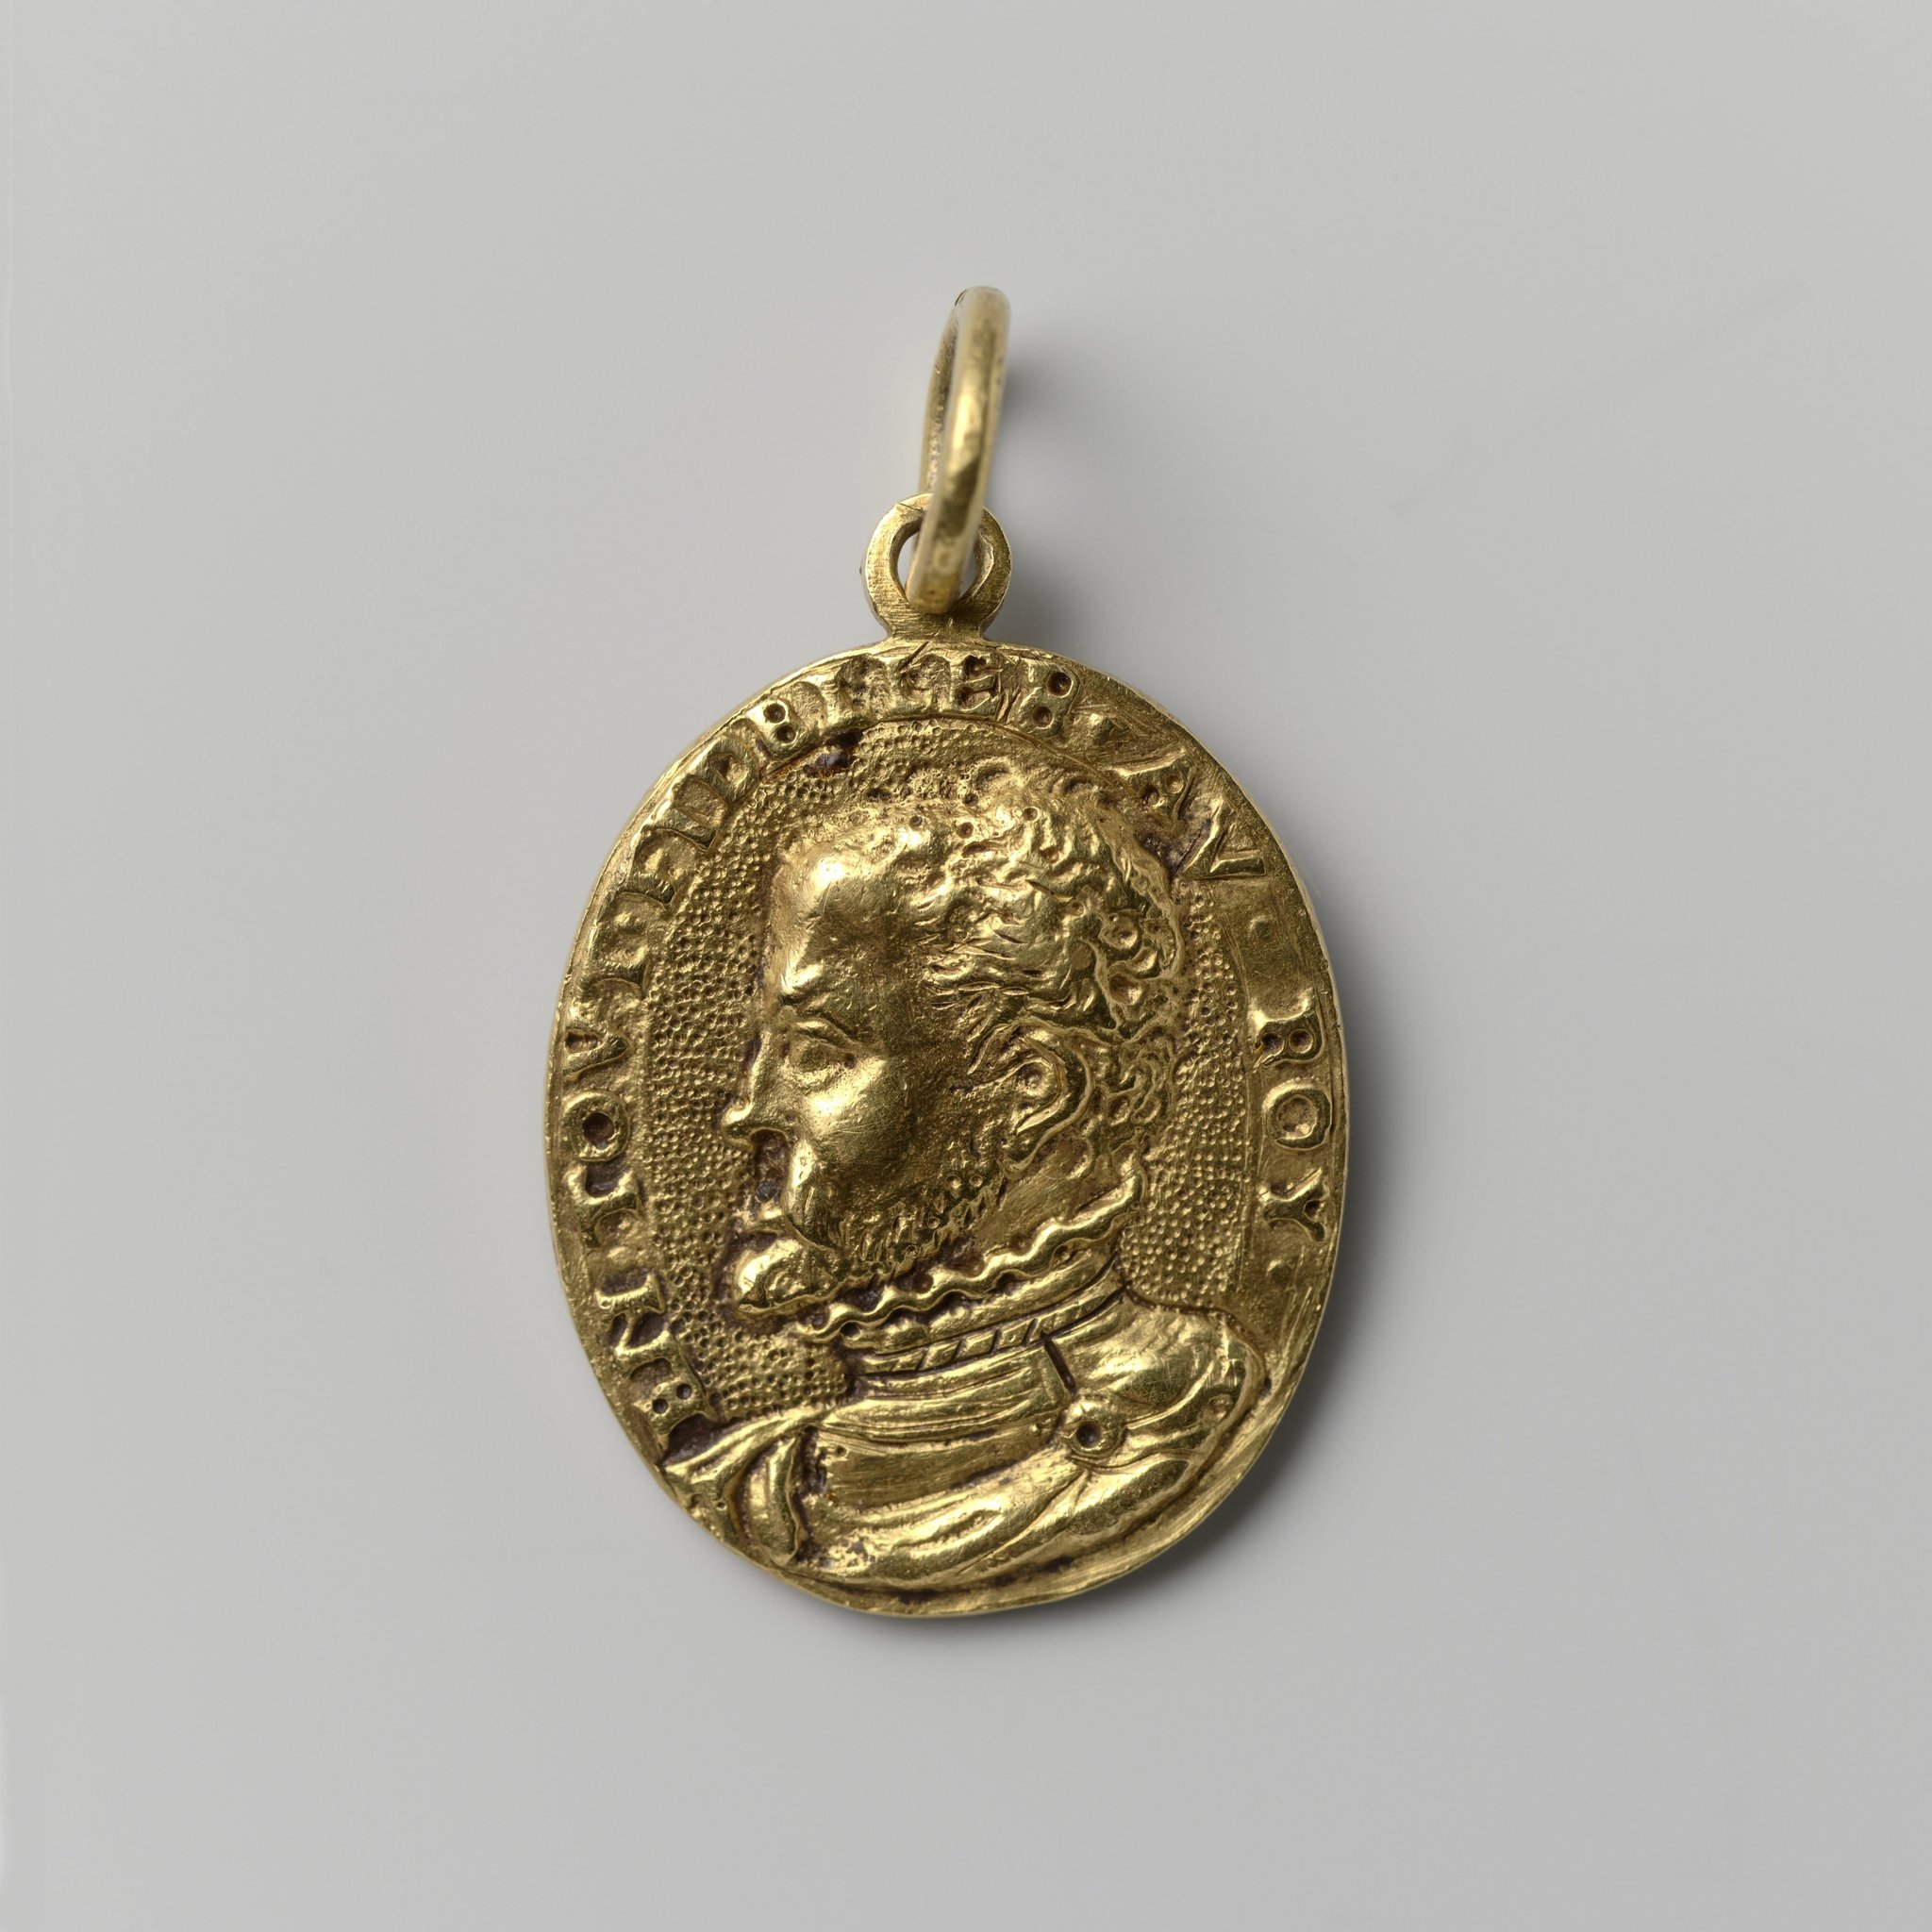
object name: medal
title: Beggars’ Medal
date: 1566-1600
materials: gold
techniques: casting, forging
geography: netherlands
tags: philip ii of spain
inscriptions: edge inscription: ‘EN. TOVT. FIDELLES. AV. ROY’, edge inscription: ‘IVSQVES. A. PORTER. LA. BESACE’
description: When in 1566 several hundred Dutch noblemen petitioned the Spanish authorities for greater tolerance in matters of religion, they were ridiculed as 'gueux': beggars. In response, they took the French name 'gueux' (vulgarised to 'geuzen') as a symbol of honour and wore a beggar's badge on their clothes. These were tokens that town authorities gave to beggars to show that they were legally allowed to beg. The crescent shape of the medals and the text around the edge 'Better Turkish than Papish' had several connotations. Turks had a reputation for cruelty; but they were also known for their tolerance to other religions. Moreover, the Islamic Turkish Empire was at war with Catholic Spain. Apart from badges, the Geuzen also carried small wooden begging bowls and flasks, reminiscent of the pilgrims who lived by begging.